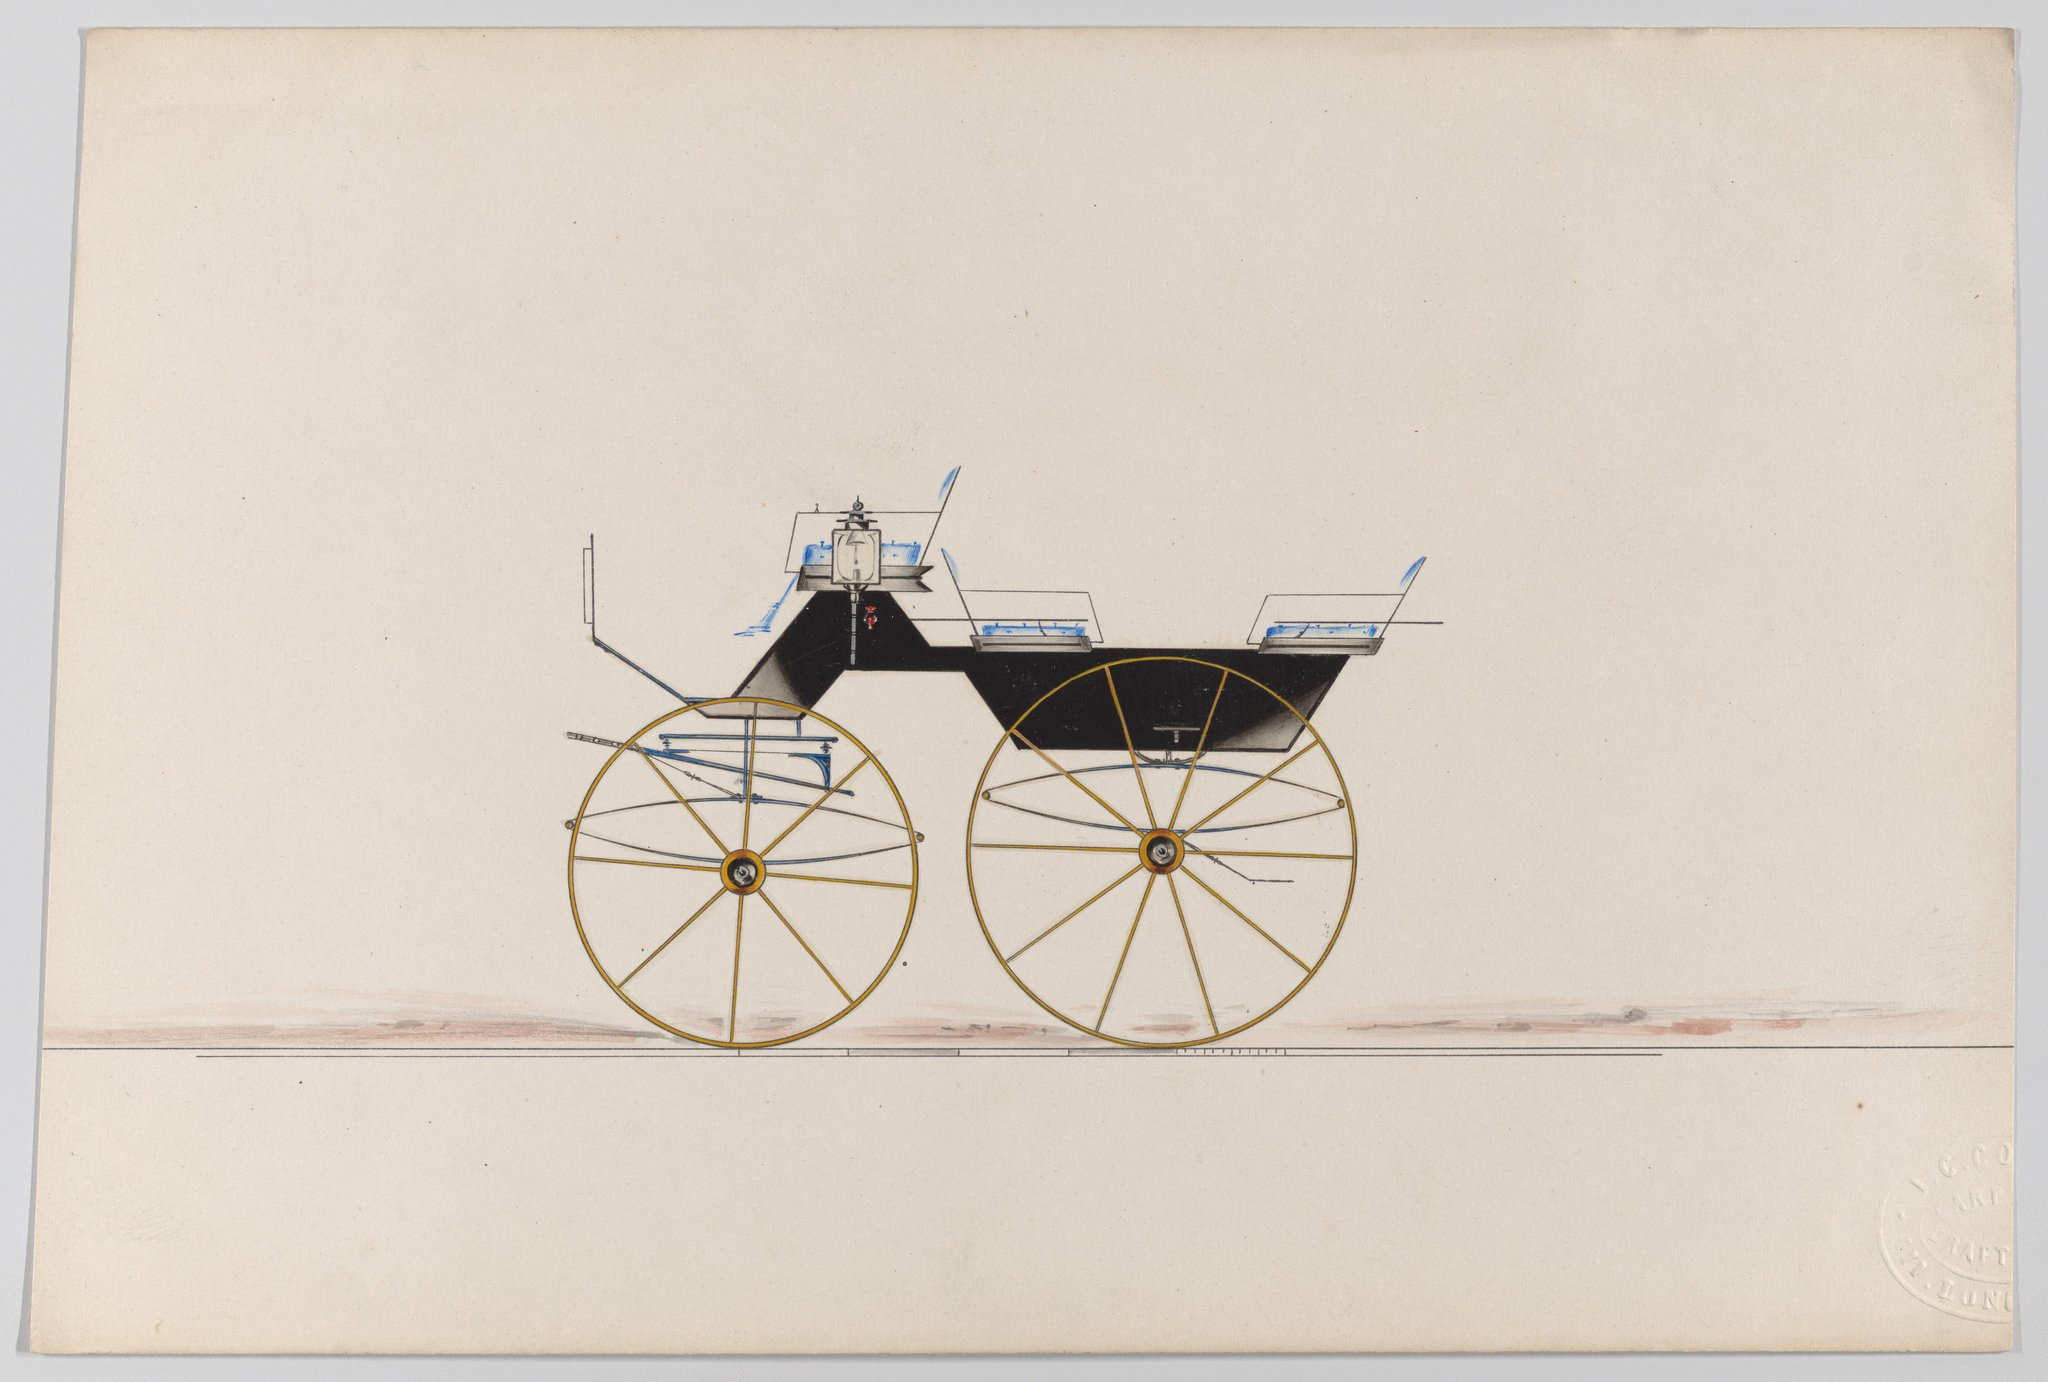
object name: drawing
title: Design for Vis-à-vis (unnumbered)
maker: brewster & co.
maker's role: manufacturer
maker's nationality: american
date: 1870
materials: gouache, gum arabic, ink, watercolor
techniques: pen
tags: carriages